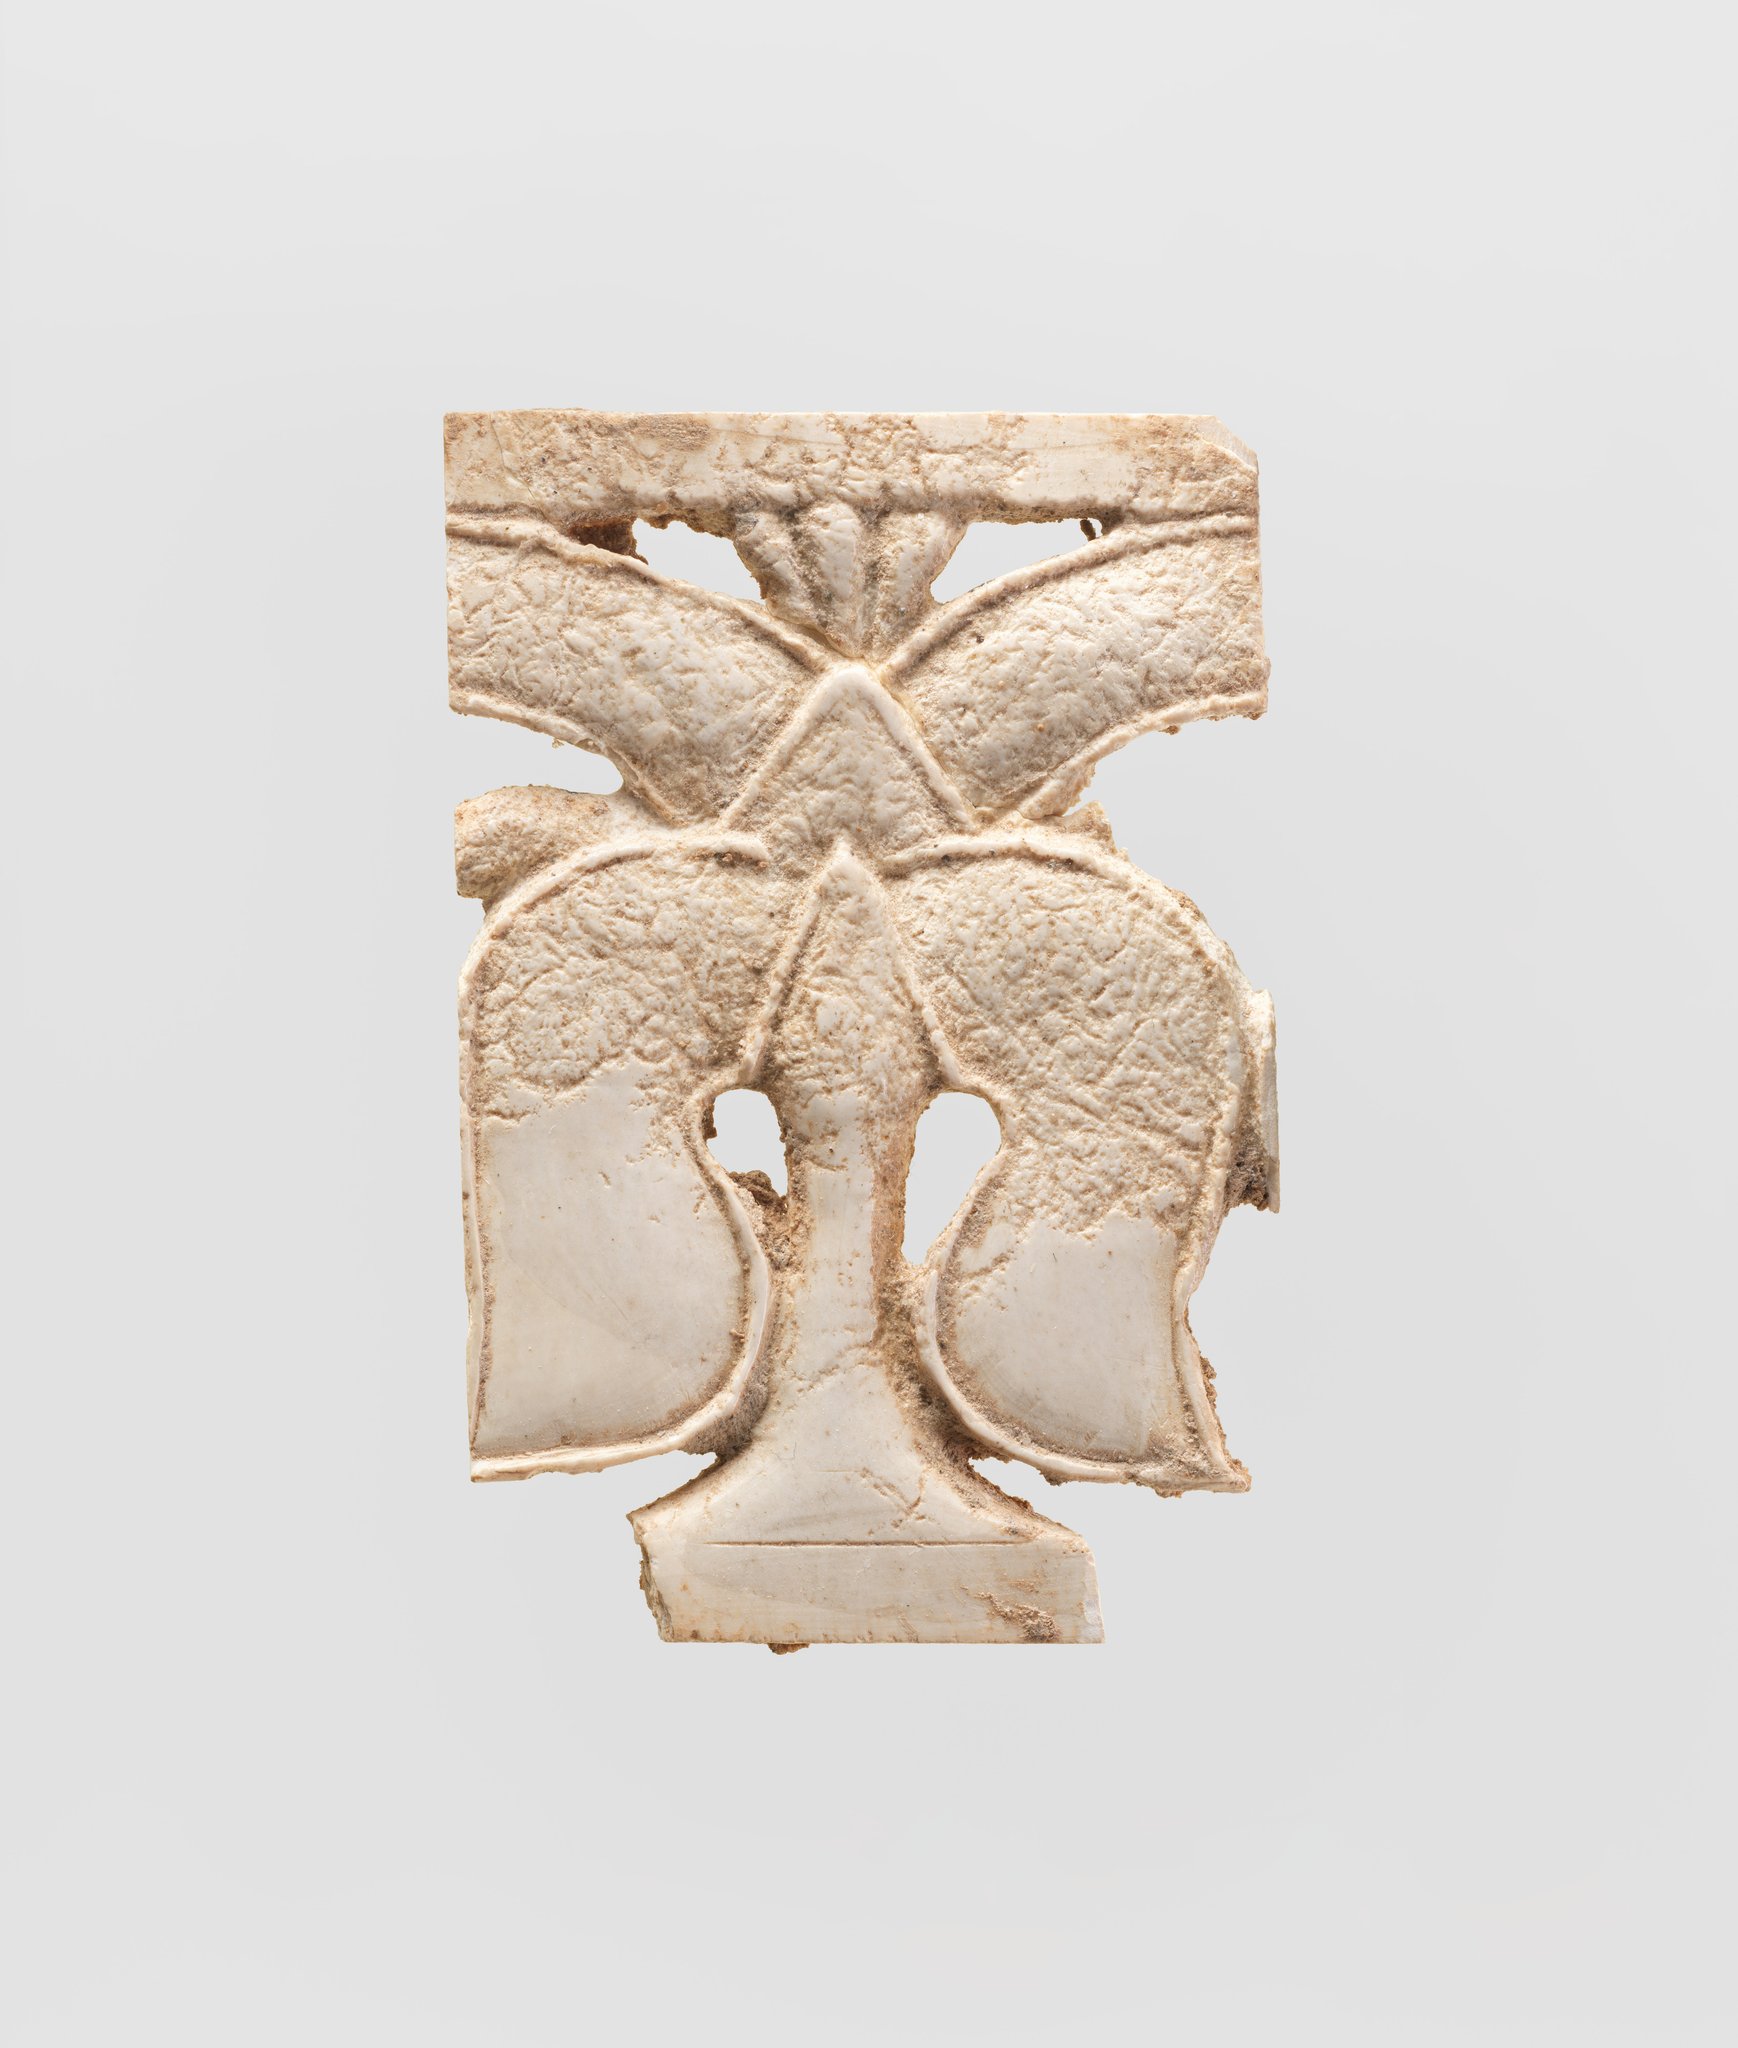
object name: relief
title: Openwork furniture plaque with leaves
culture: assyrian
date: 900-701 BCE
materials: ivory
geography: mesopotamia